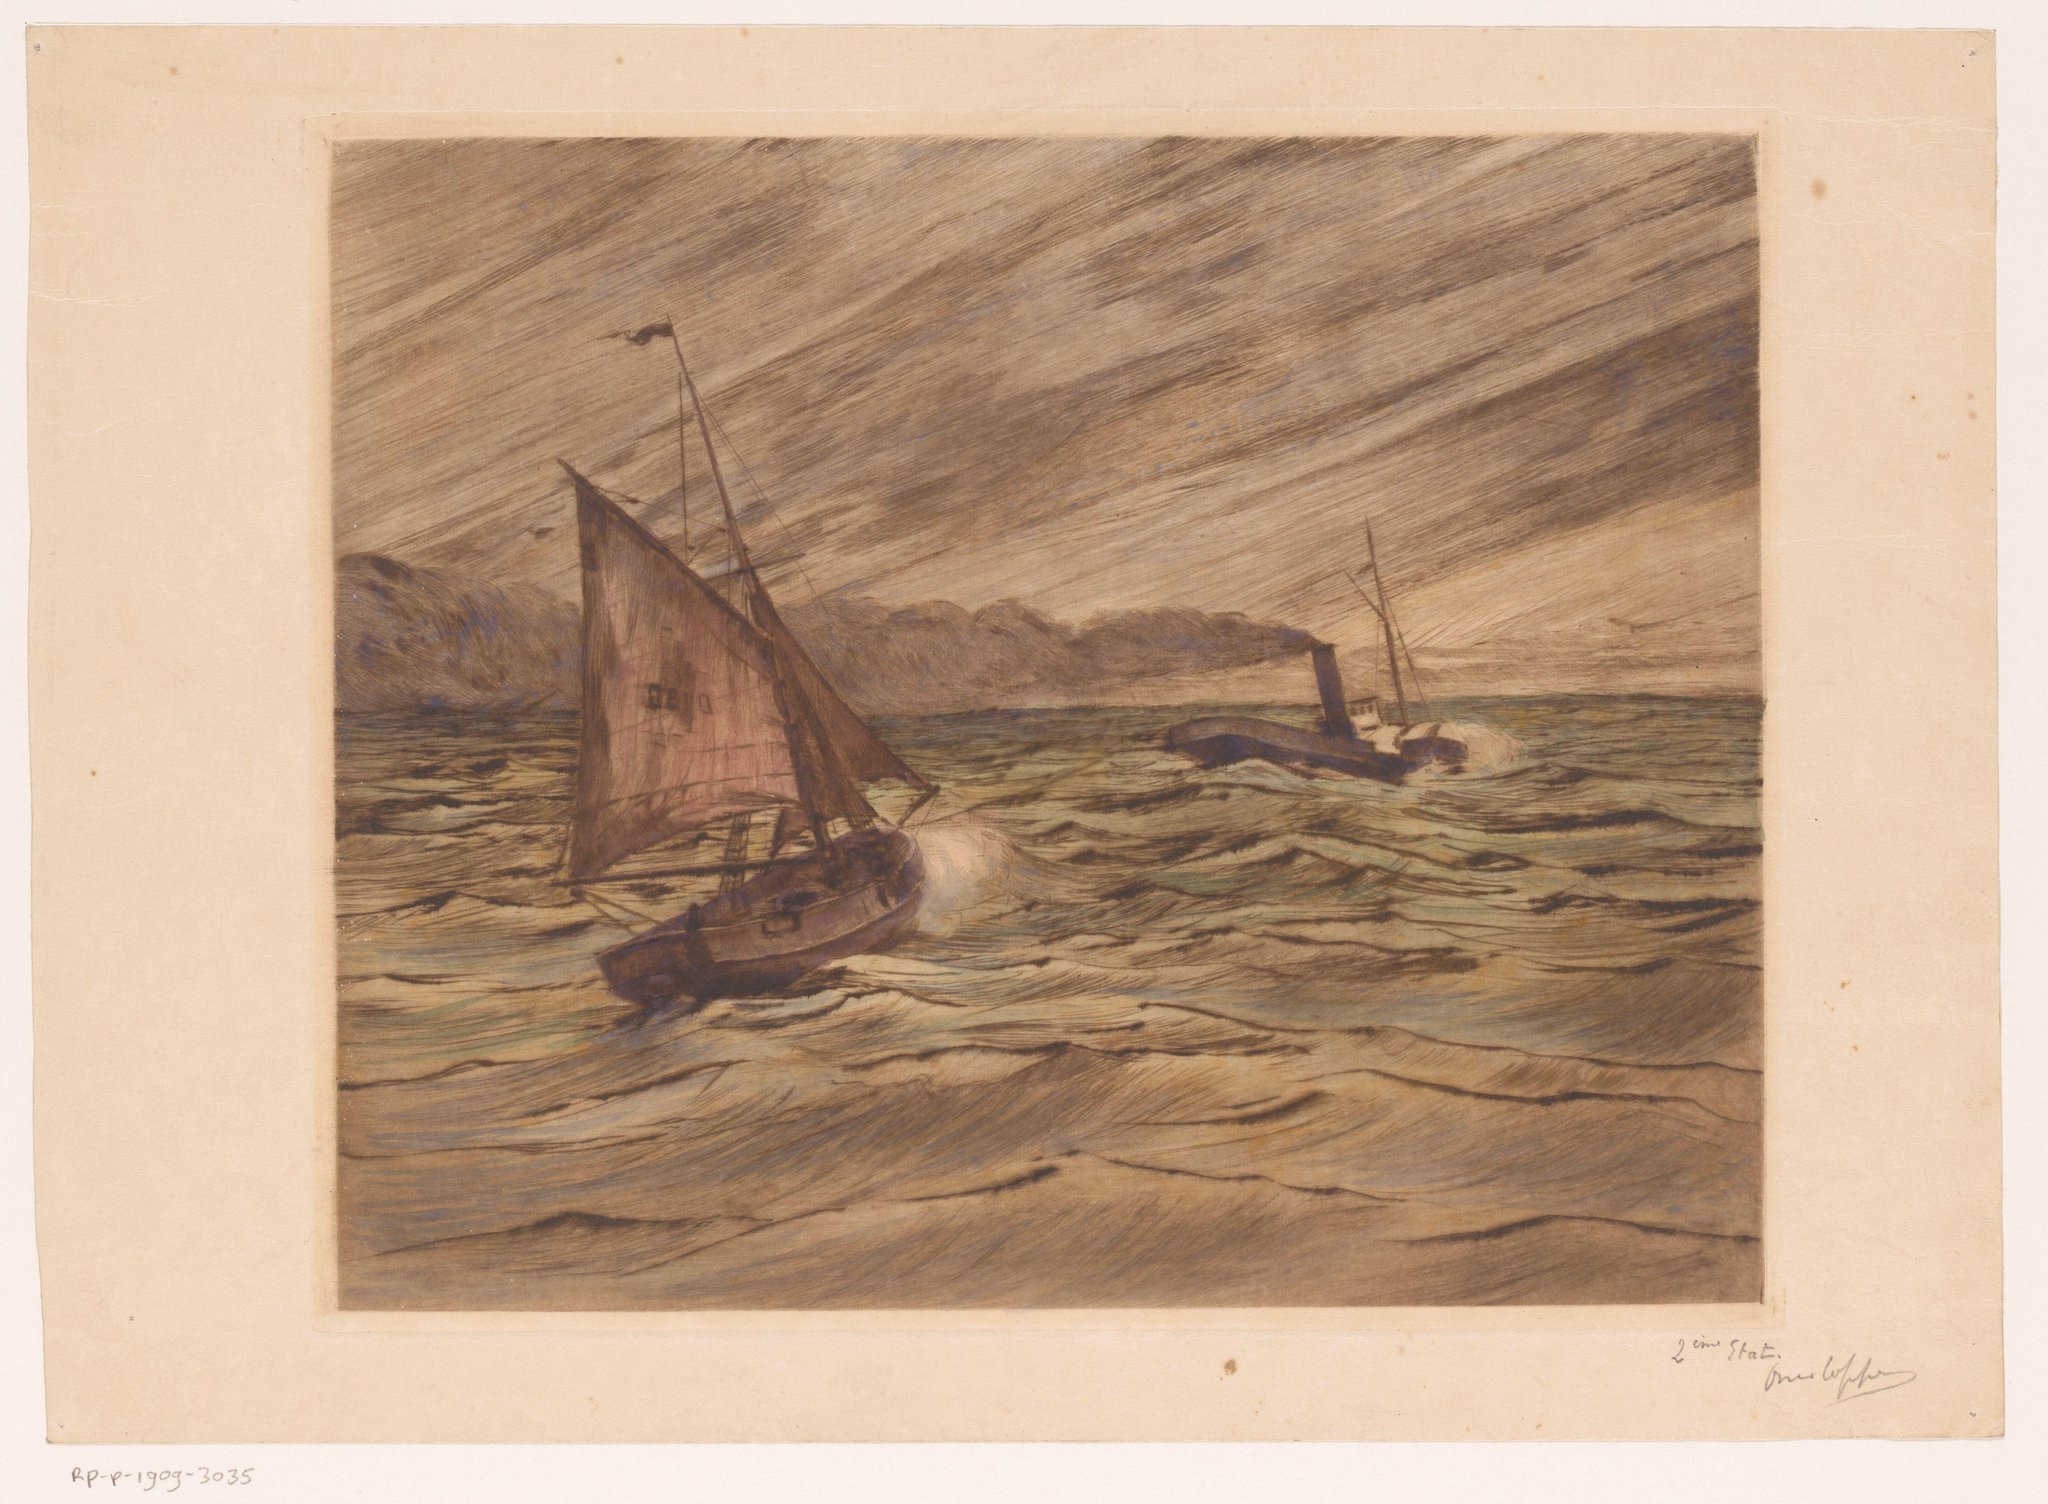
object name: print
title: Twee schepen op zee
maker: omer coppens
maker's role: print maker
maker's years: 1864-1926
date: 1874-1909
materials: paper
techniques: drypoint, etching, hand coloring, intaglio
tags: sailing-ship, sailing-boat, steamship, motorship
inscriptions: collector's mark: Lugt 2228, inscription: ‘2eme Etat’